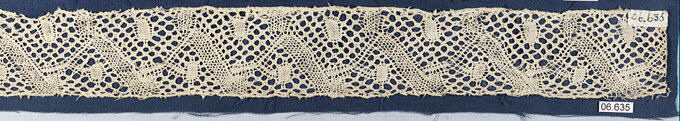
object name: strip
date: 1701-1800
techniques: lace